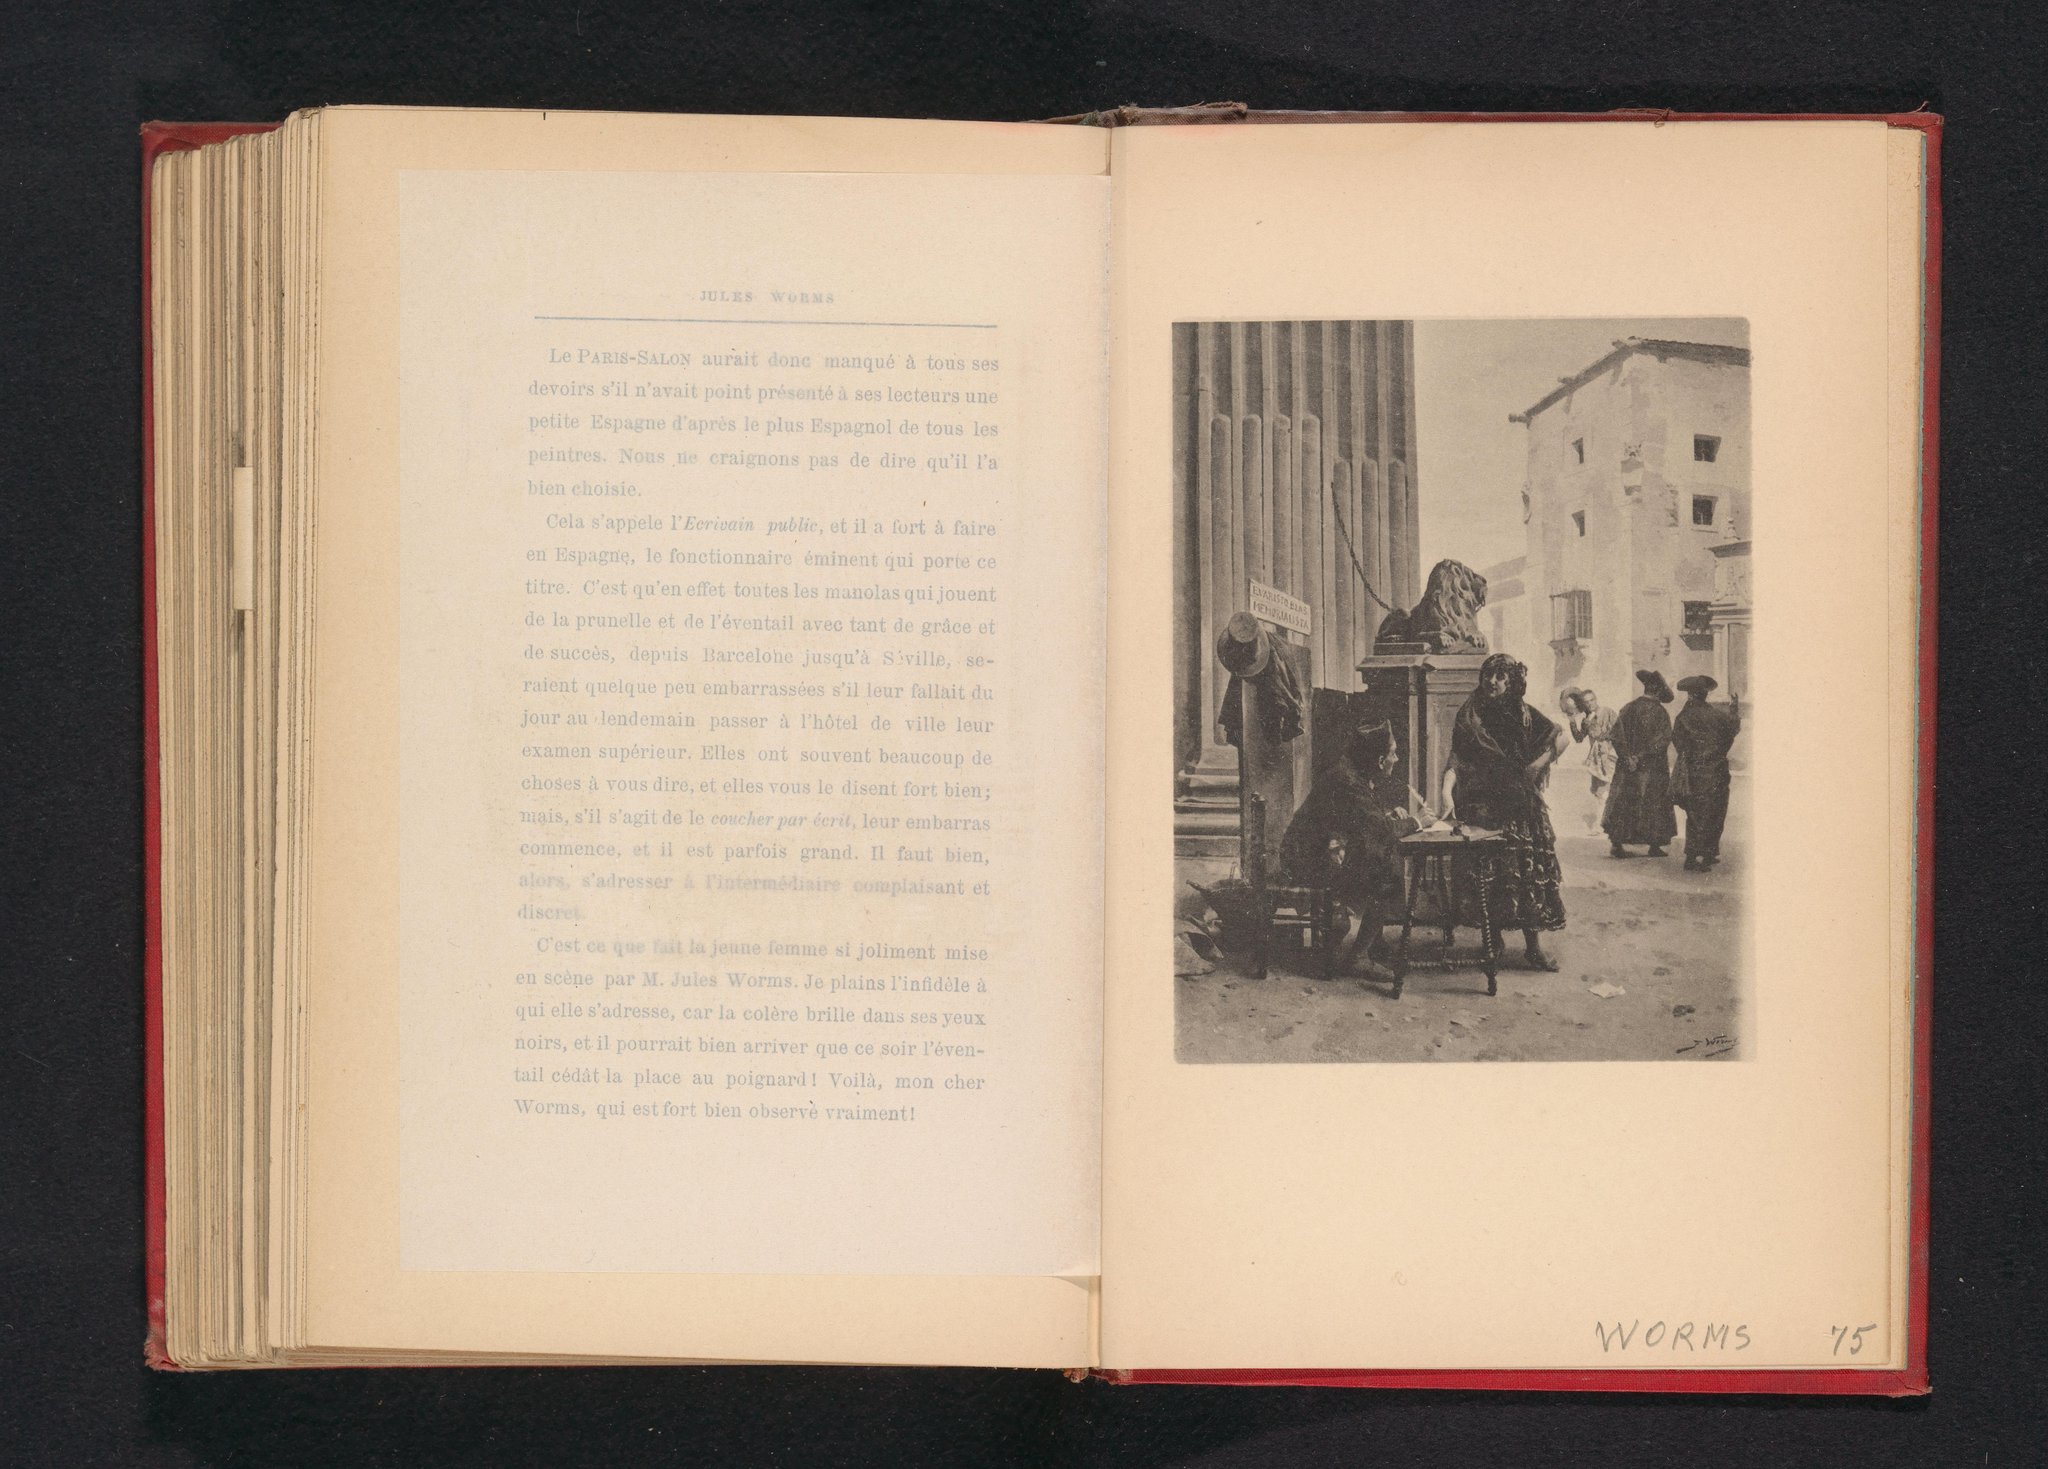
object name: page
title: Fotoreproductie van het schilderij Un écrivain public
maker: jules worms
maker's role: painter, print maker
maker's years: 1832-1924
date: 1872-1882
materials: paper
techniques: photograph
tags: author, poet writing (+ out of doors), writer, poet, author